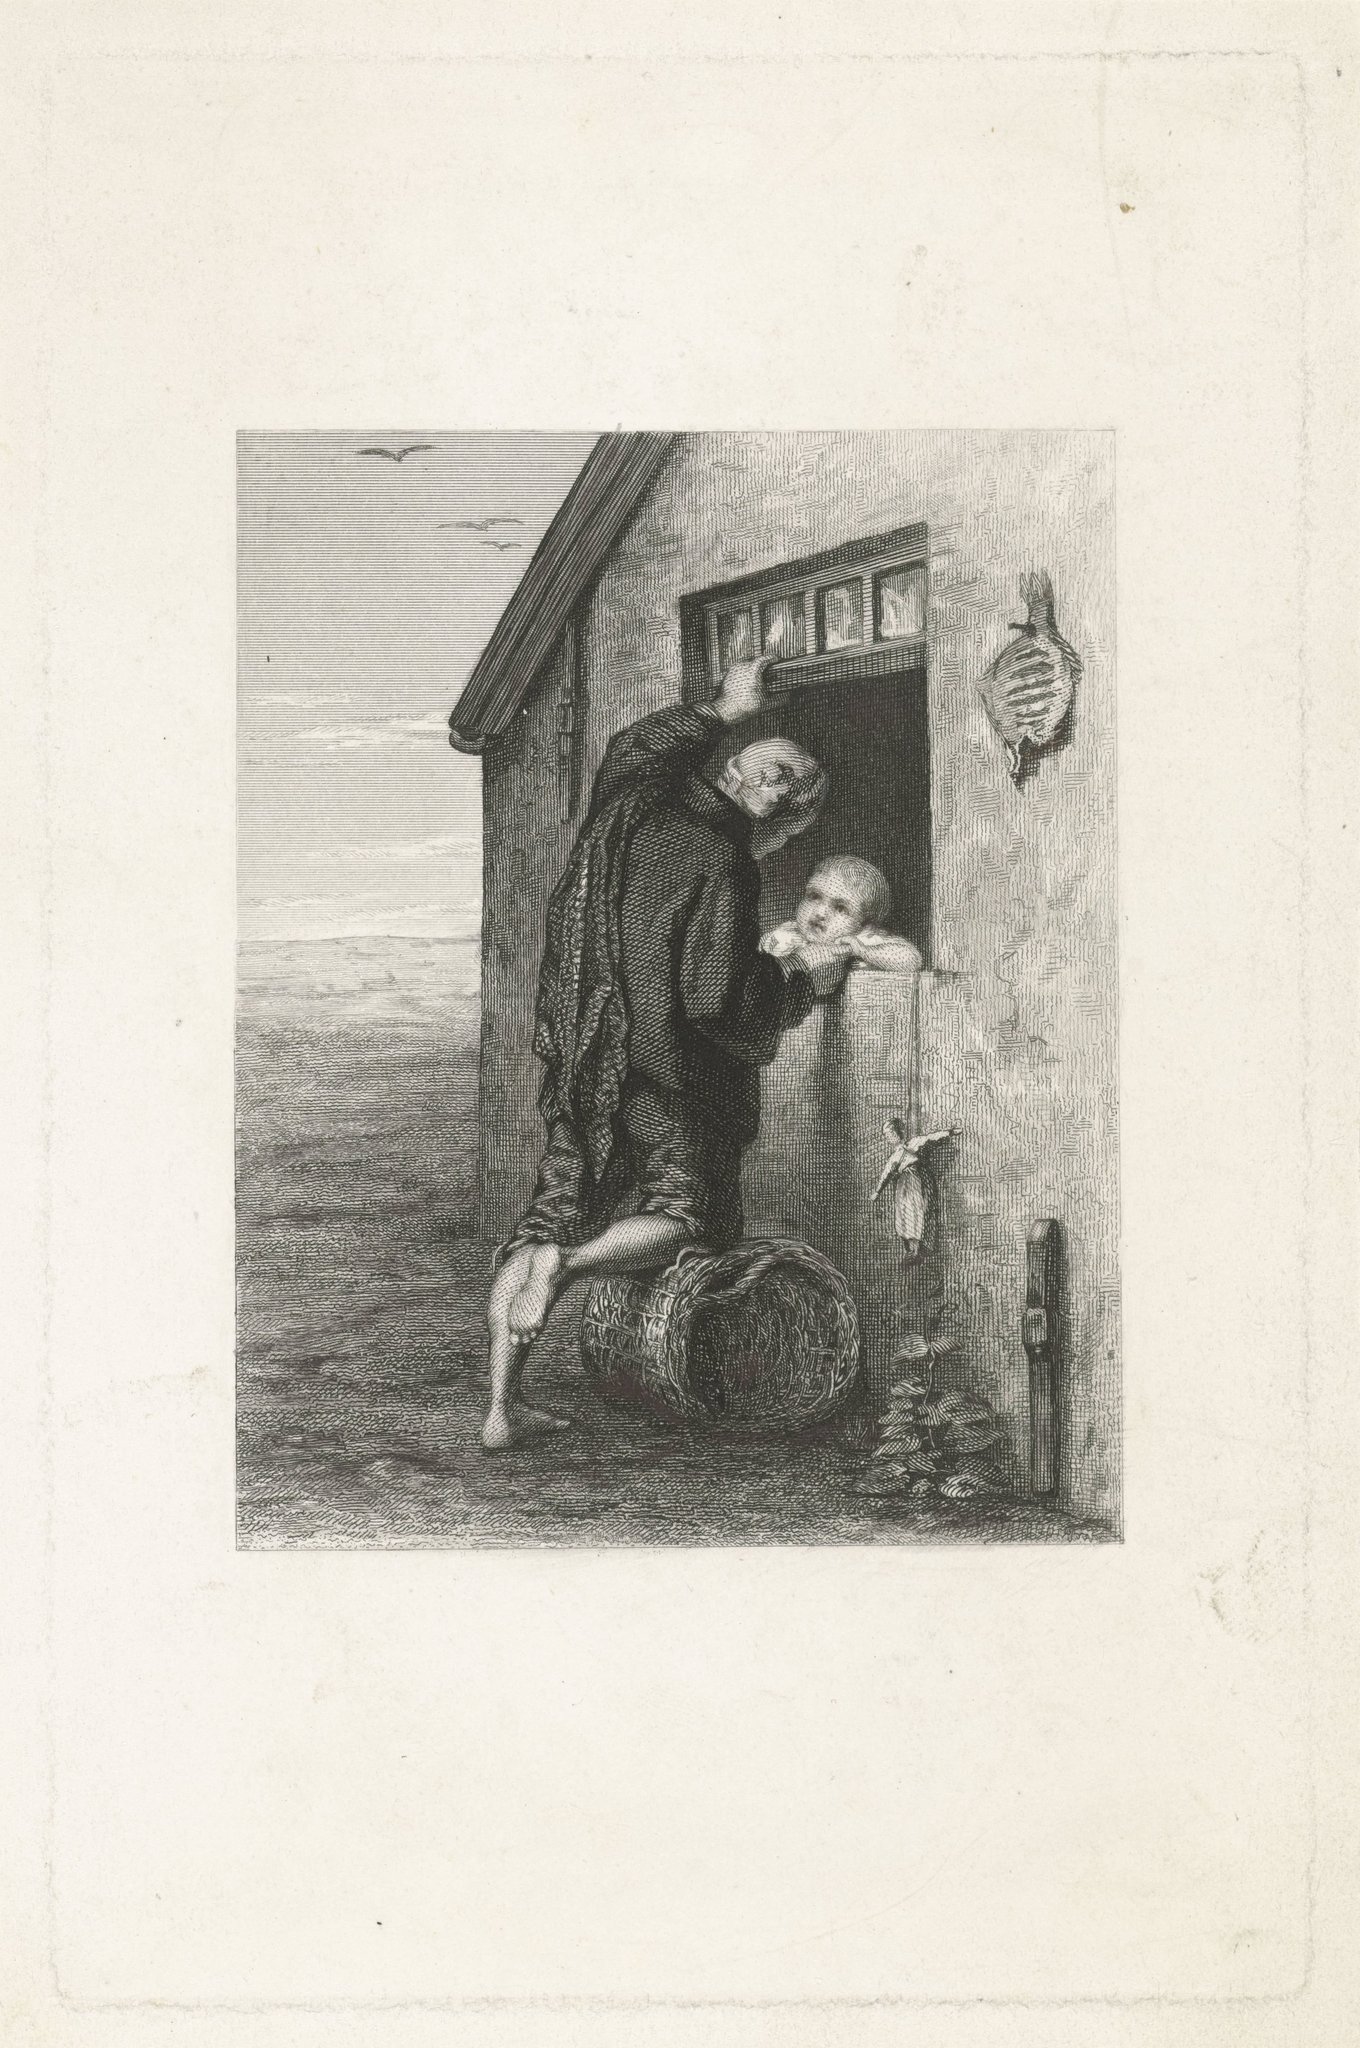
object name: print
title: Gesprek tussen een visser en een kind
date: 1755-1877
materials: paper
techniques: roulette, engraving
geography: amsterdam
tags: (playing with) dolls, conversation, dialogue; conversation piece, beach, fisherman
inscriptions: collector's mark: Lugt 2228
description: Een visser staat voor het raam van een huis te praten met een klein kind. Hij leunt met zijn knie op een rieten mand en het kind laat een pop aan een touw door het venster naar buiten bungelen. Op de achtergrond het strand en de zee.